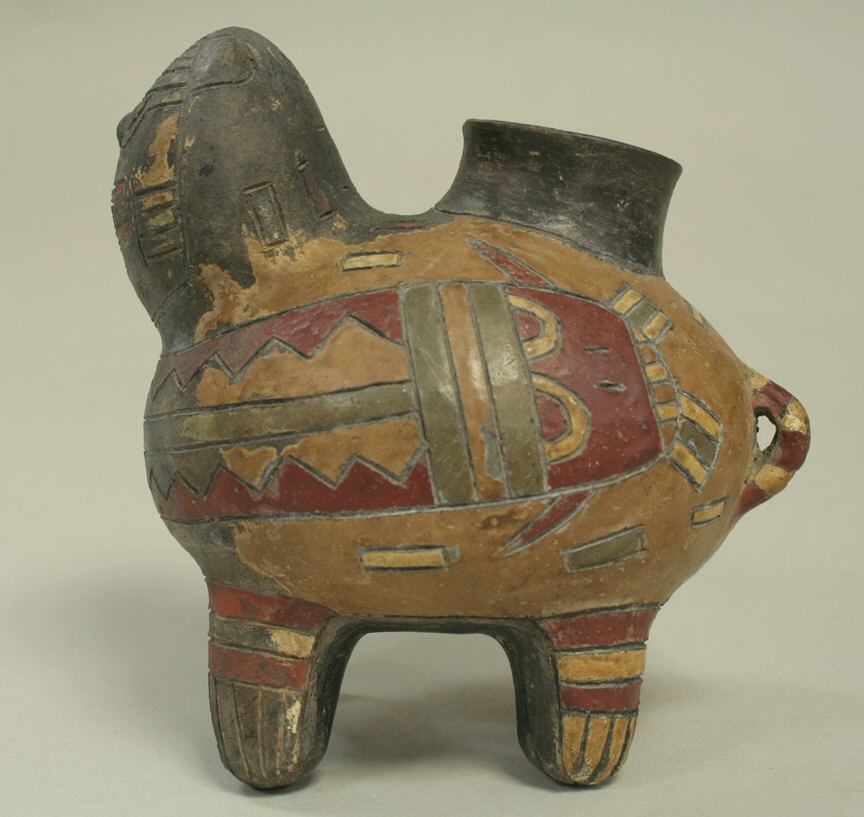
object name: bottle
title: Feline Bottle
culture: paracas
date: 500-201 BCE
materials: ceramic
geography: peru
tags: cats